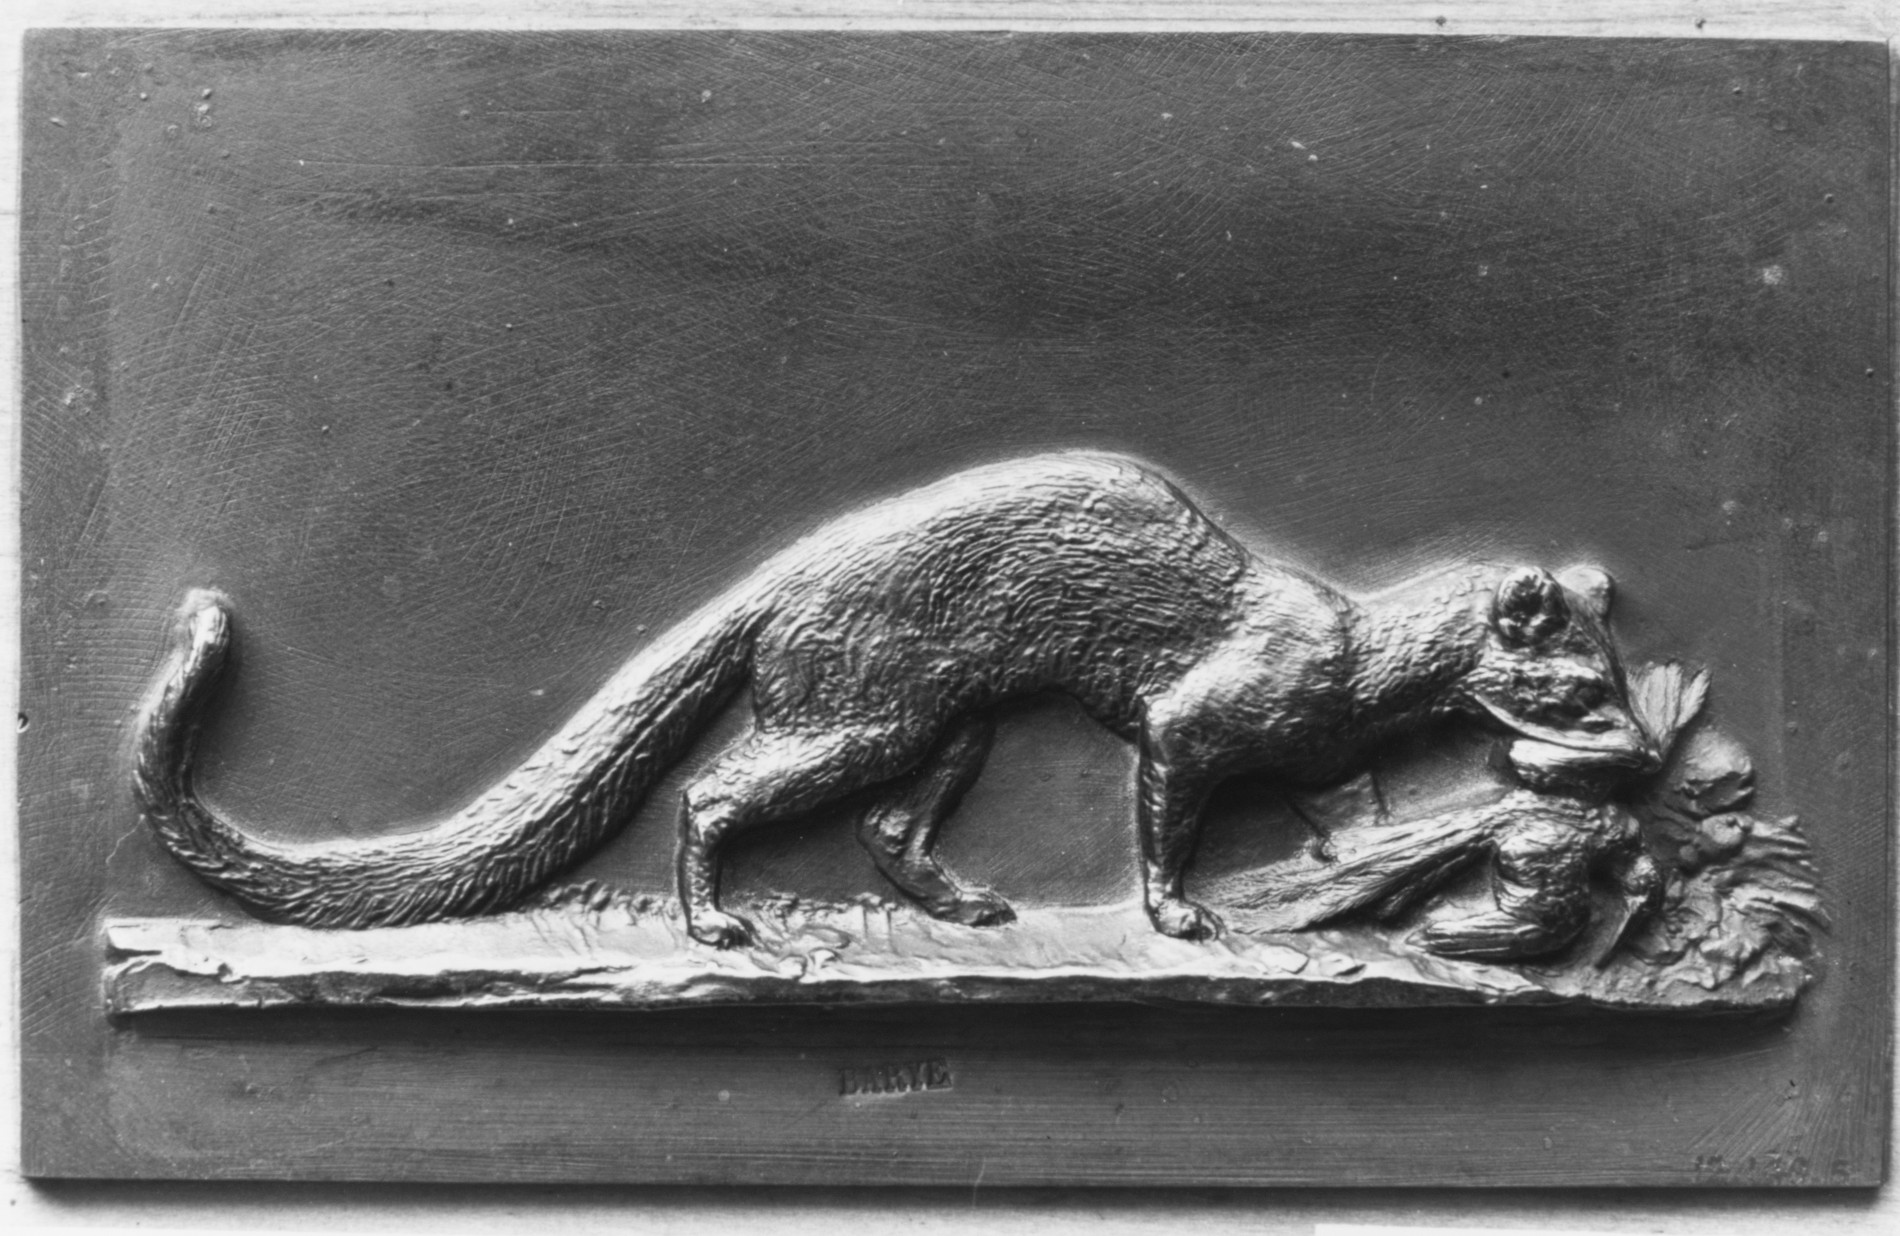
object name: plaquette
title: Genet dragging a bird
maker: antoine-louis barye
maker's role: artist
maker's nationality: french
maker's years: 1795-1875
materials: bronze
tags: animals,birds